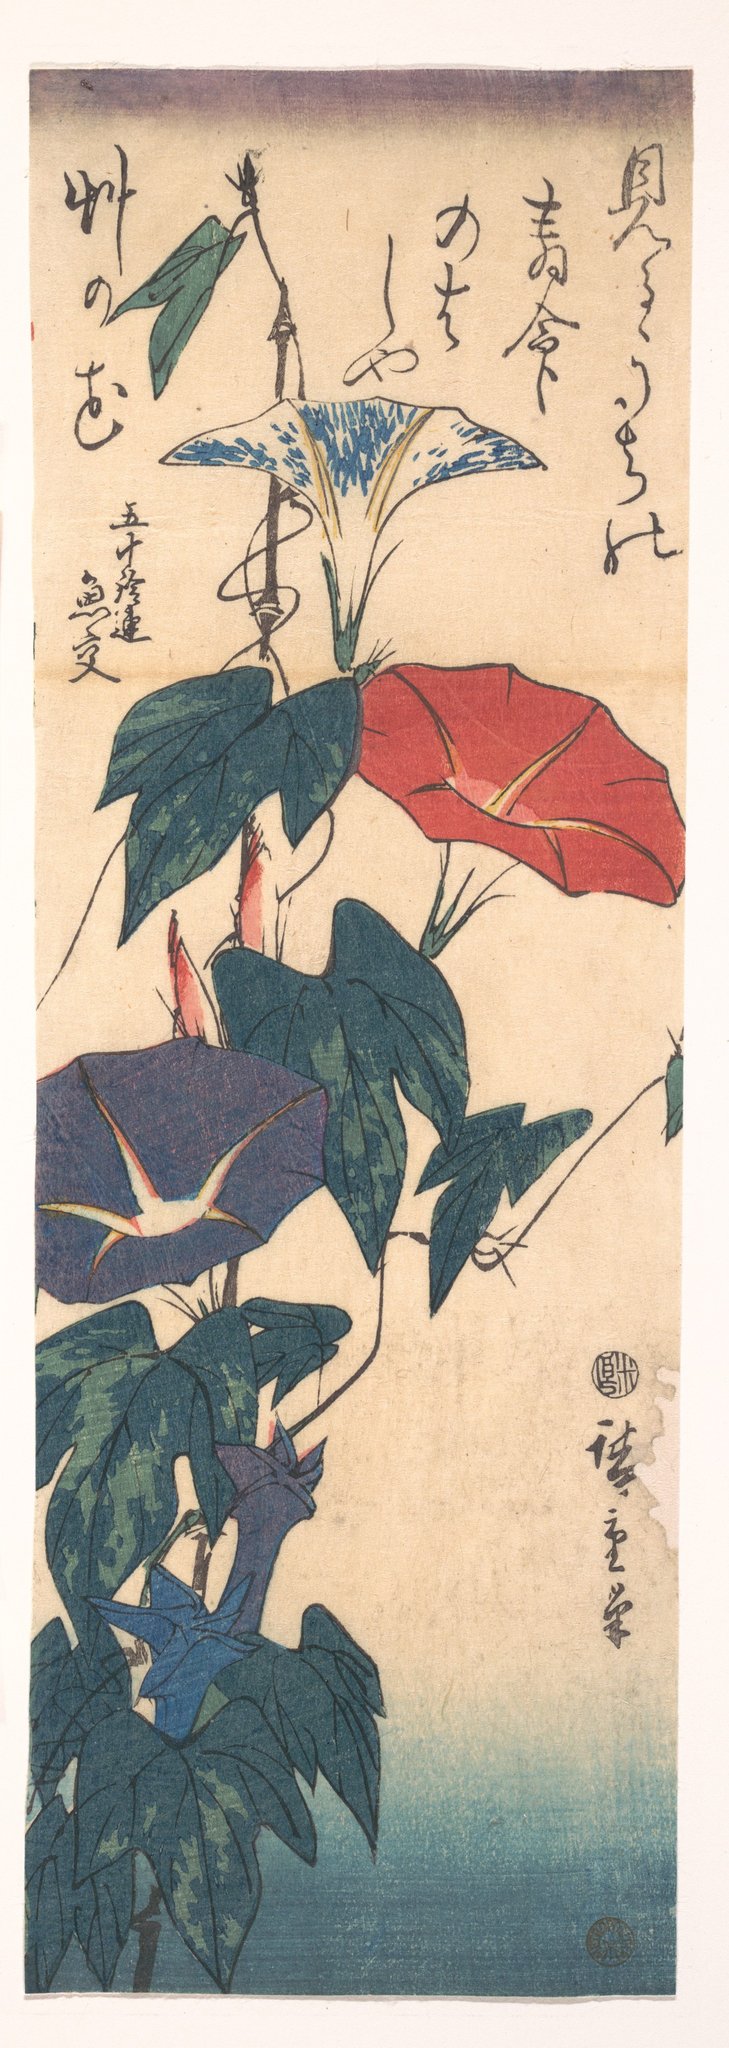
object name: print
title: Morning Glories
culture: japanese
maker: utagawa hiroshige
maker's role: artist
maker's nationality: japanese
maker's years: 1797-1858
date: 1843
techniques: woodblock print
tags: flowers,leaves